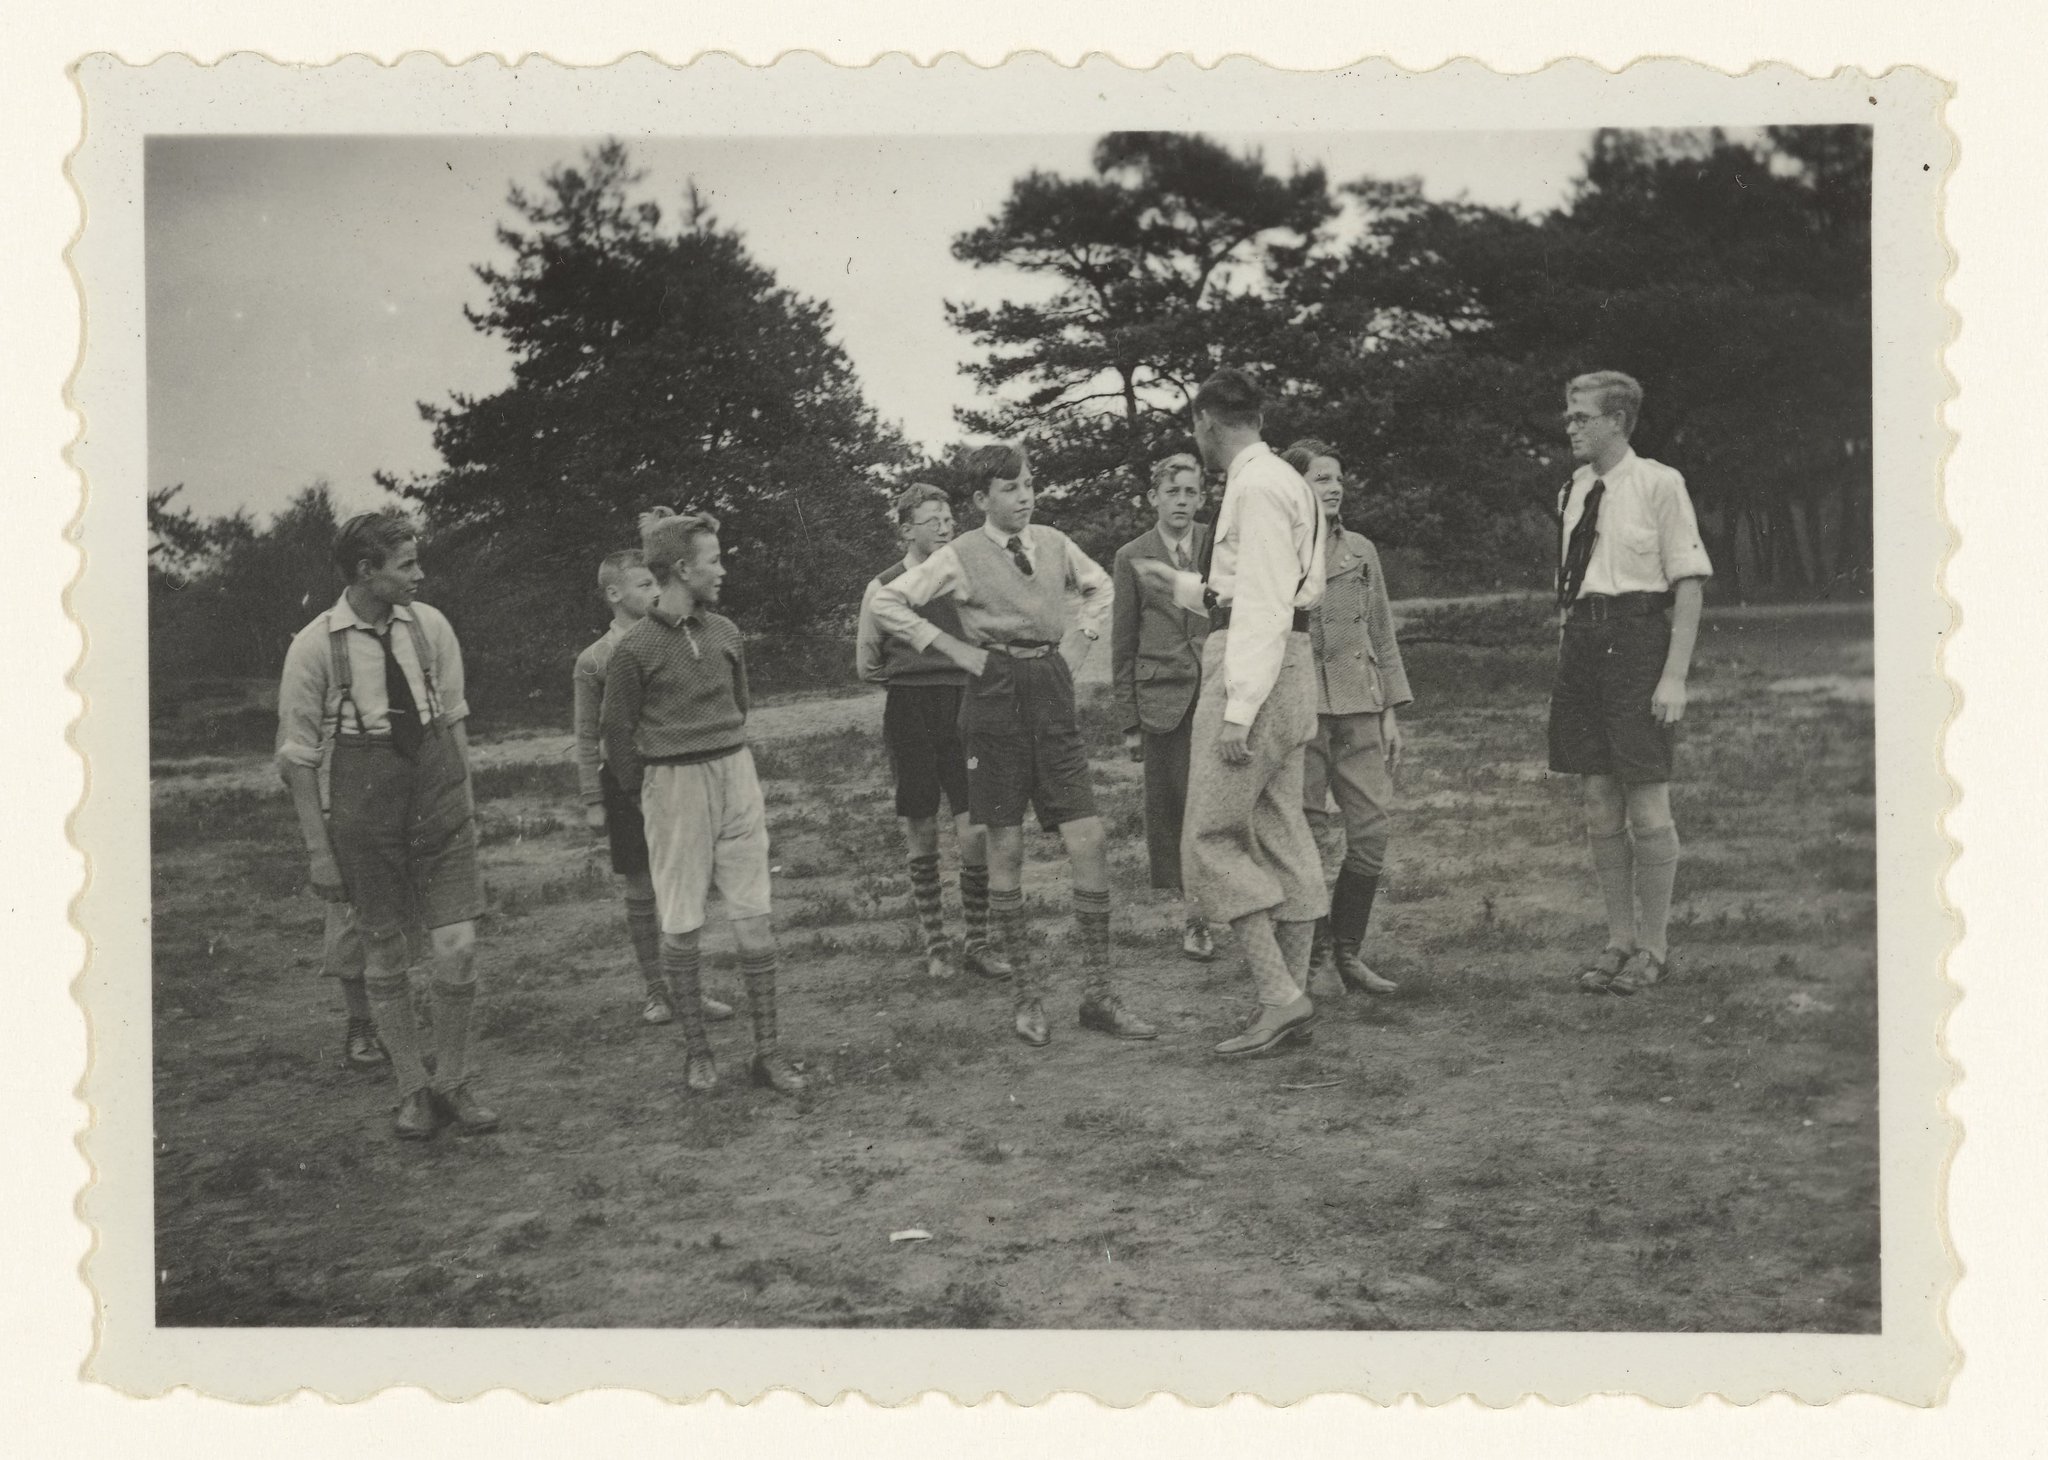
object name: photograph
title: Jongens van de Jeugdstorm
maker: Anonymous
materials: photographic support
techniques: photography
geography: bilthoven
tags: official, running games (children)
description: Jongens van de Jeugdstorm luisteren naar Van Geelkerken, (in plusfour) leider van de Jeugdstorm, op een jeugdkamp. De meeste jongens dragen geen uniform.